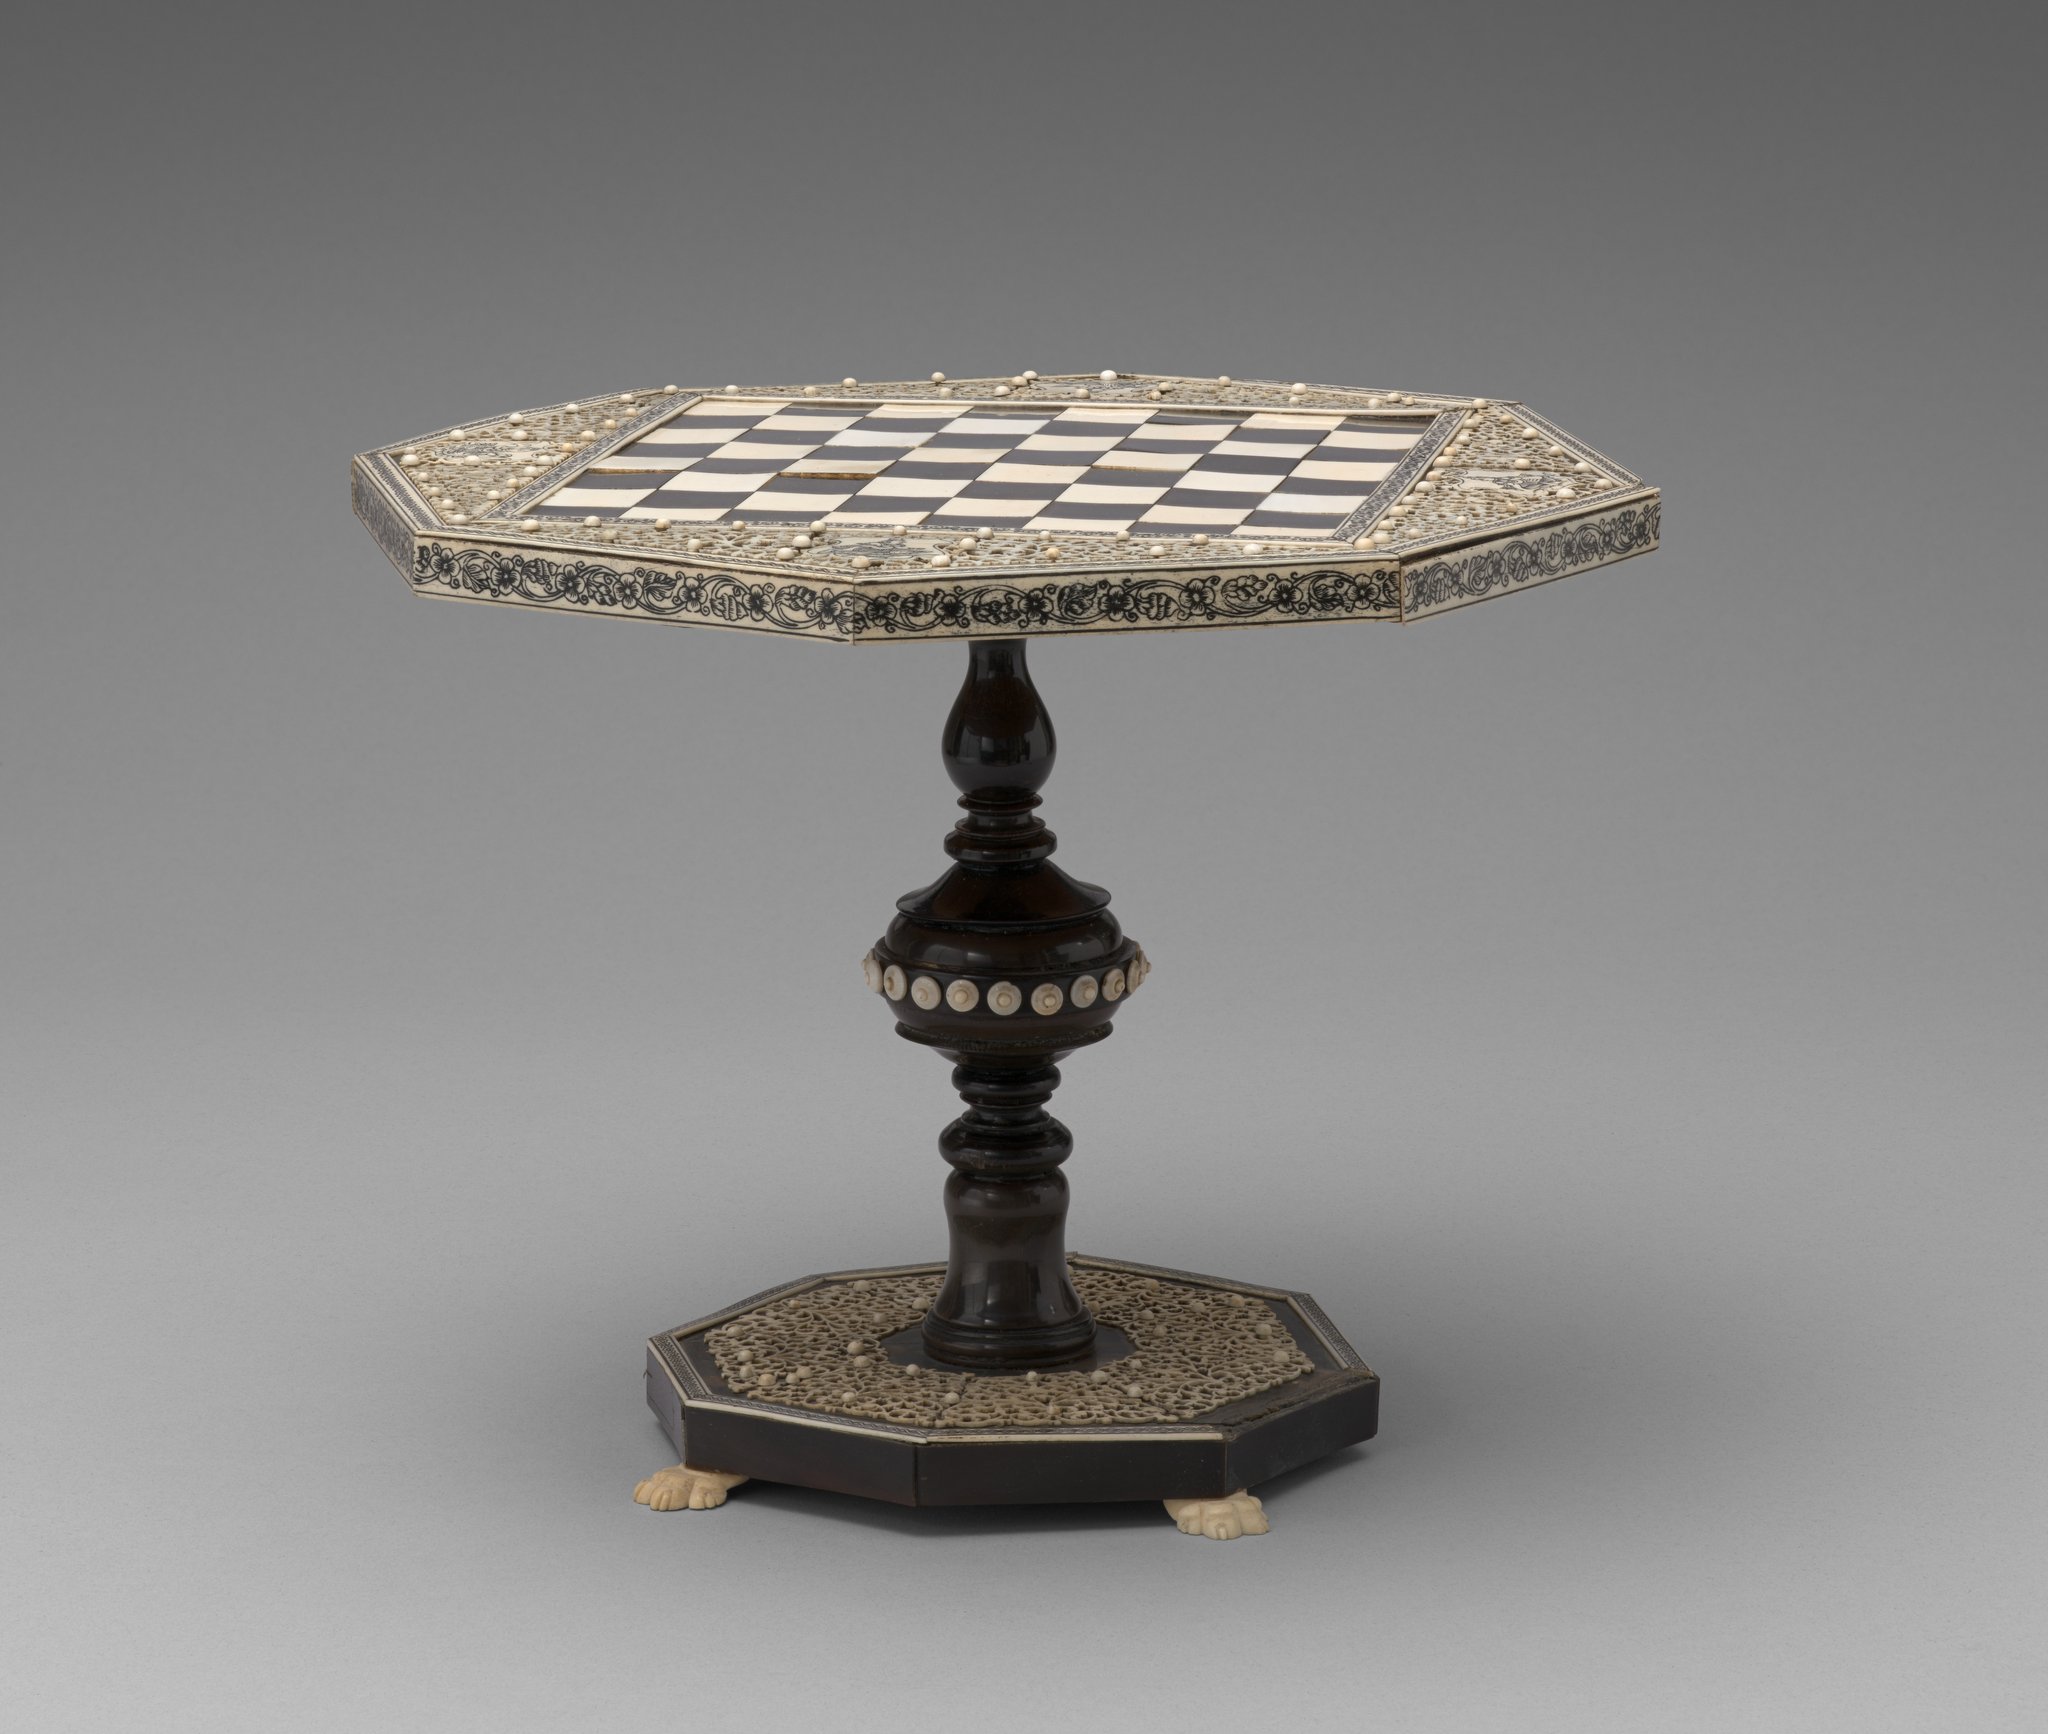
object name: chessboard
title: Miniature pedestal table with inlaid chessboard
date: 1801-1900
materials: horn, ivory, wood